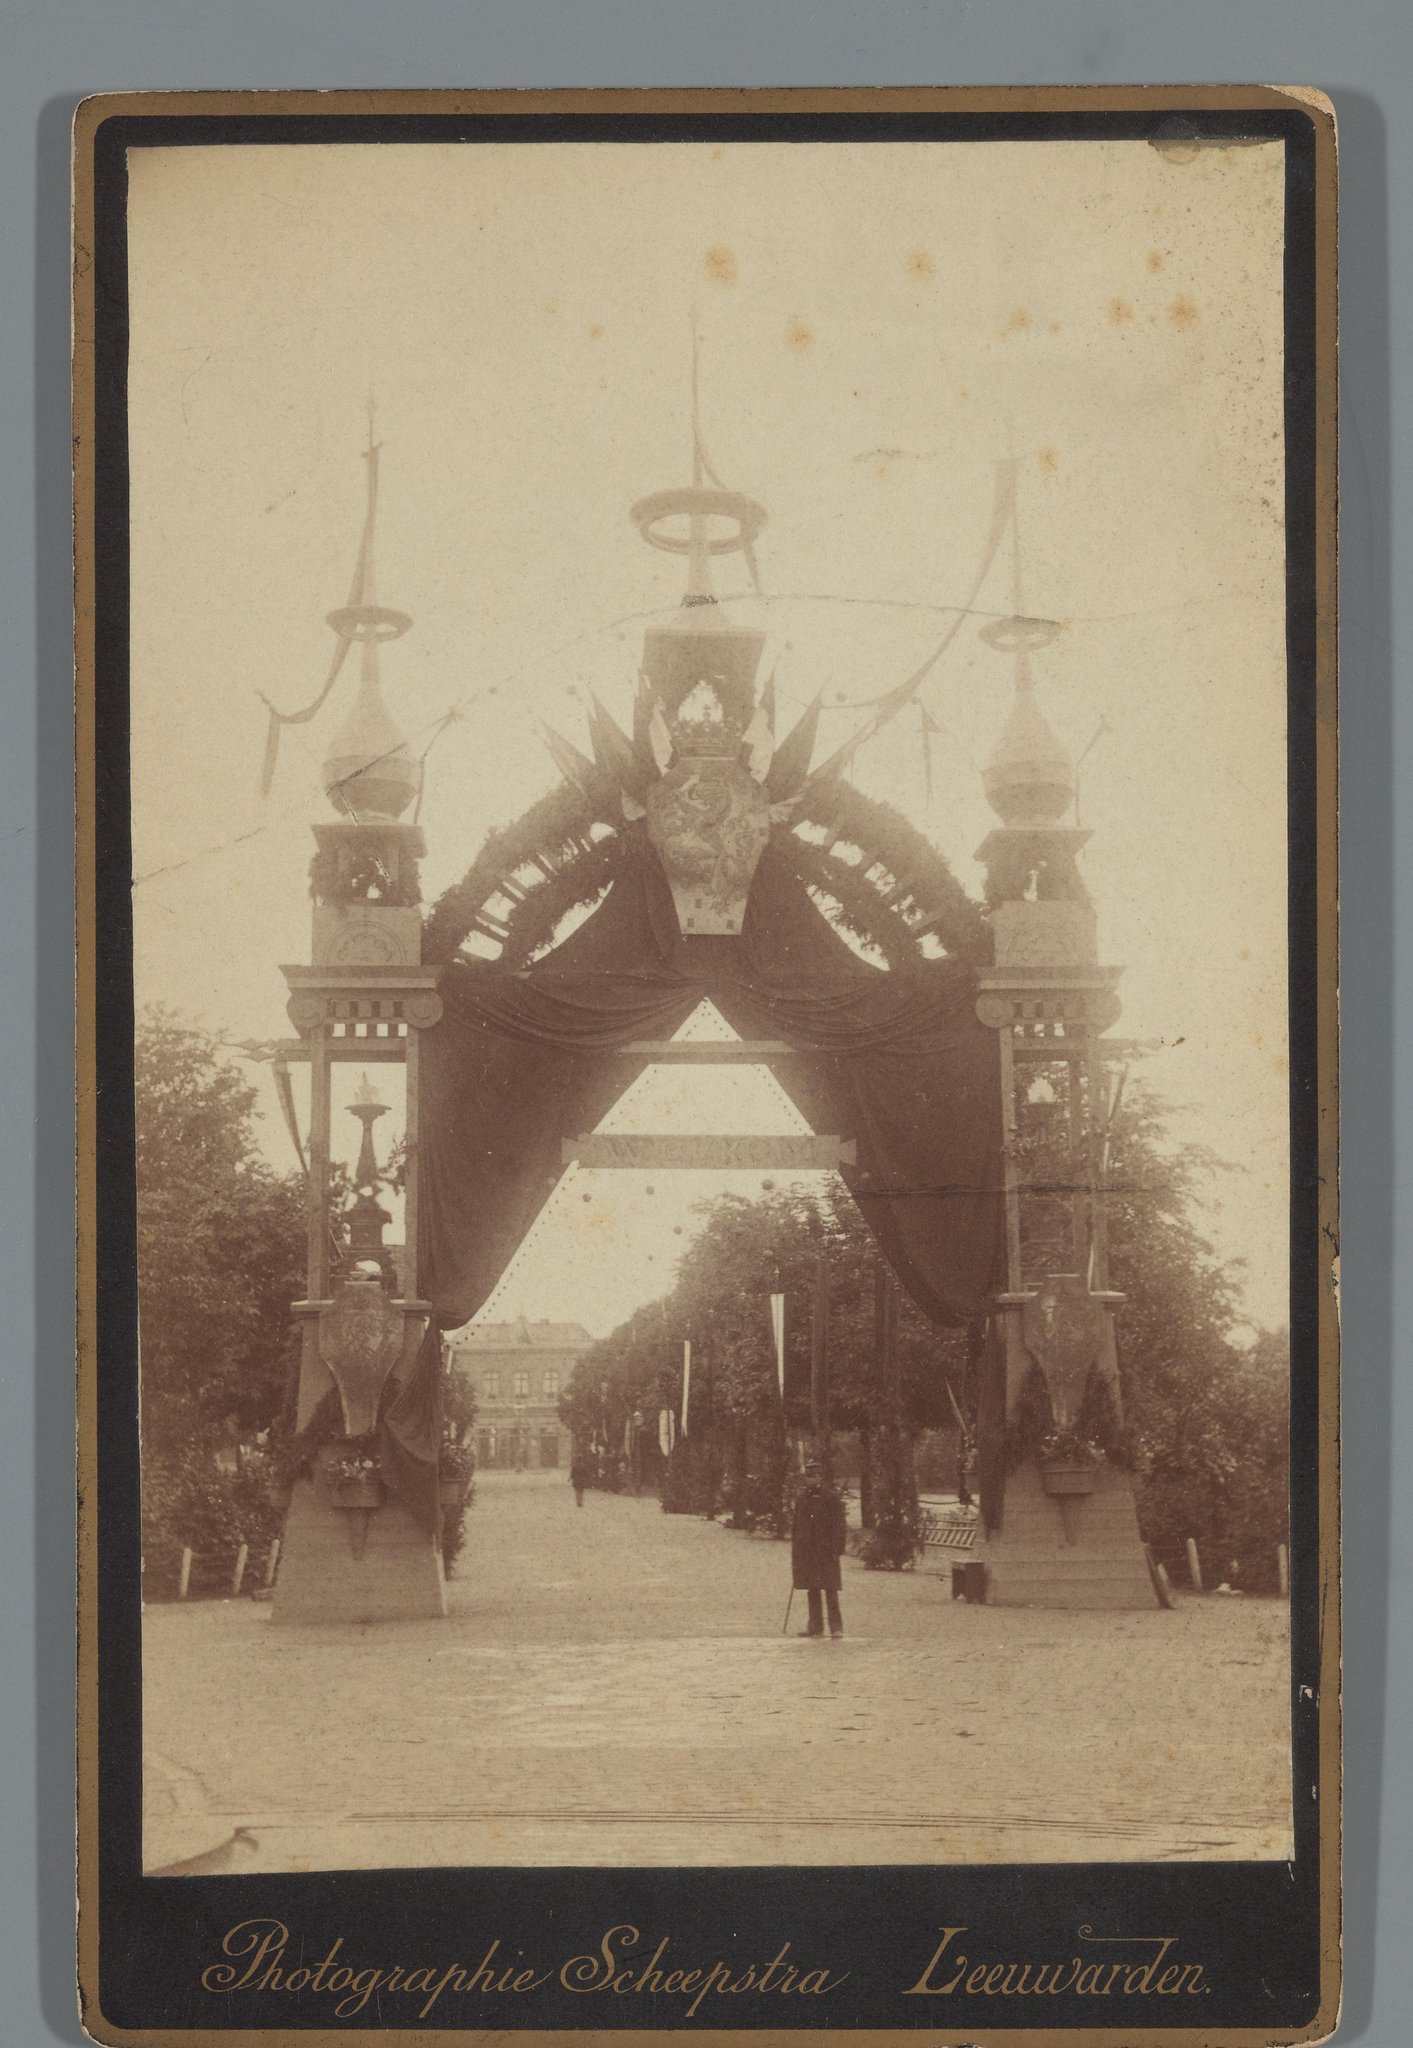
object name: photograph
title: Versieringen in Leeuwarden ter gelegenheid van de inhuldiging van koningin Wilhelmina, 1898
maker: mindert scheepstra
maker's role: fotograaf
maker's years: 1865-1951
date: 1898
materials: cardboard, paper, photographic support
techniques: albumen print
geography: leeuwarden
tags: the hague, print maker, wilhelmina of the netherlands, public festivities at other royal events, not meant or mentioned above (+ festive decoration ~ festive activities), amsterdam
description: Versieringen in Leeuwarden ter gelegenheid van de inhuldiging van koningin Wilhelmina op 6 september 1898.